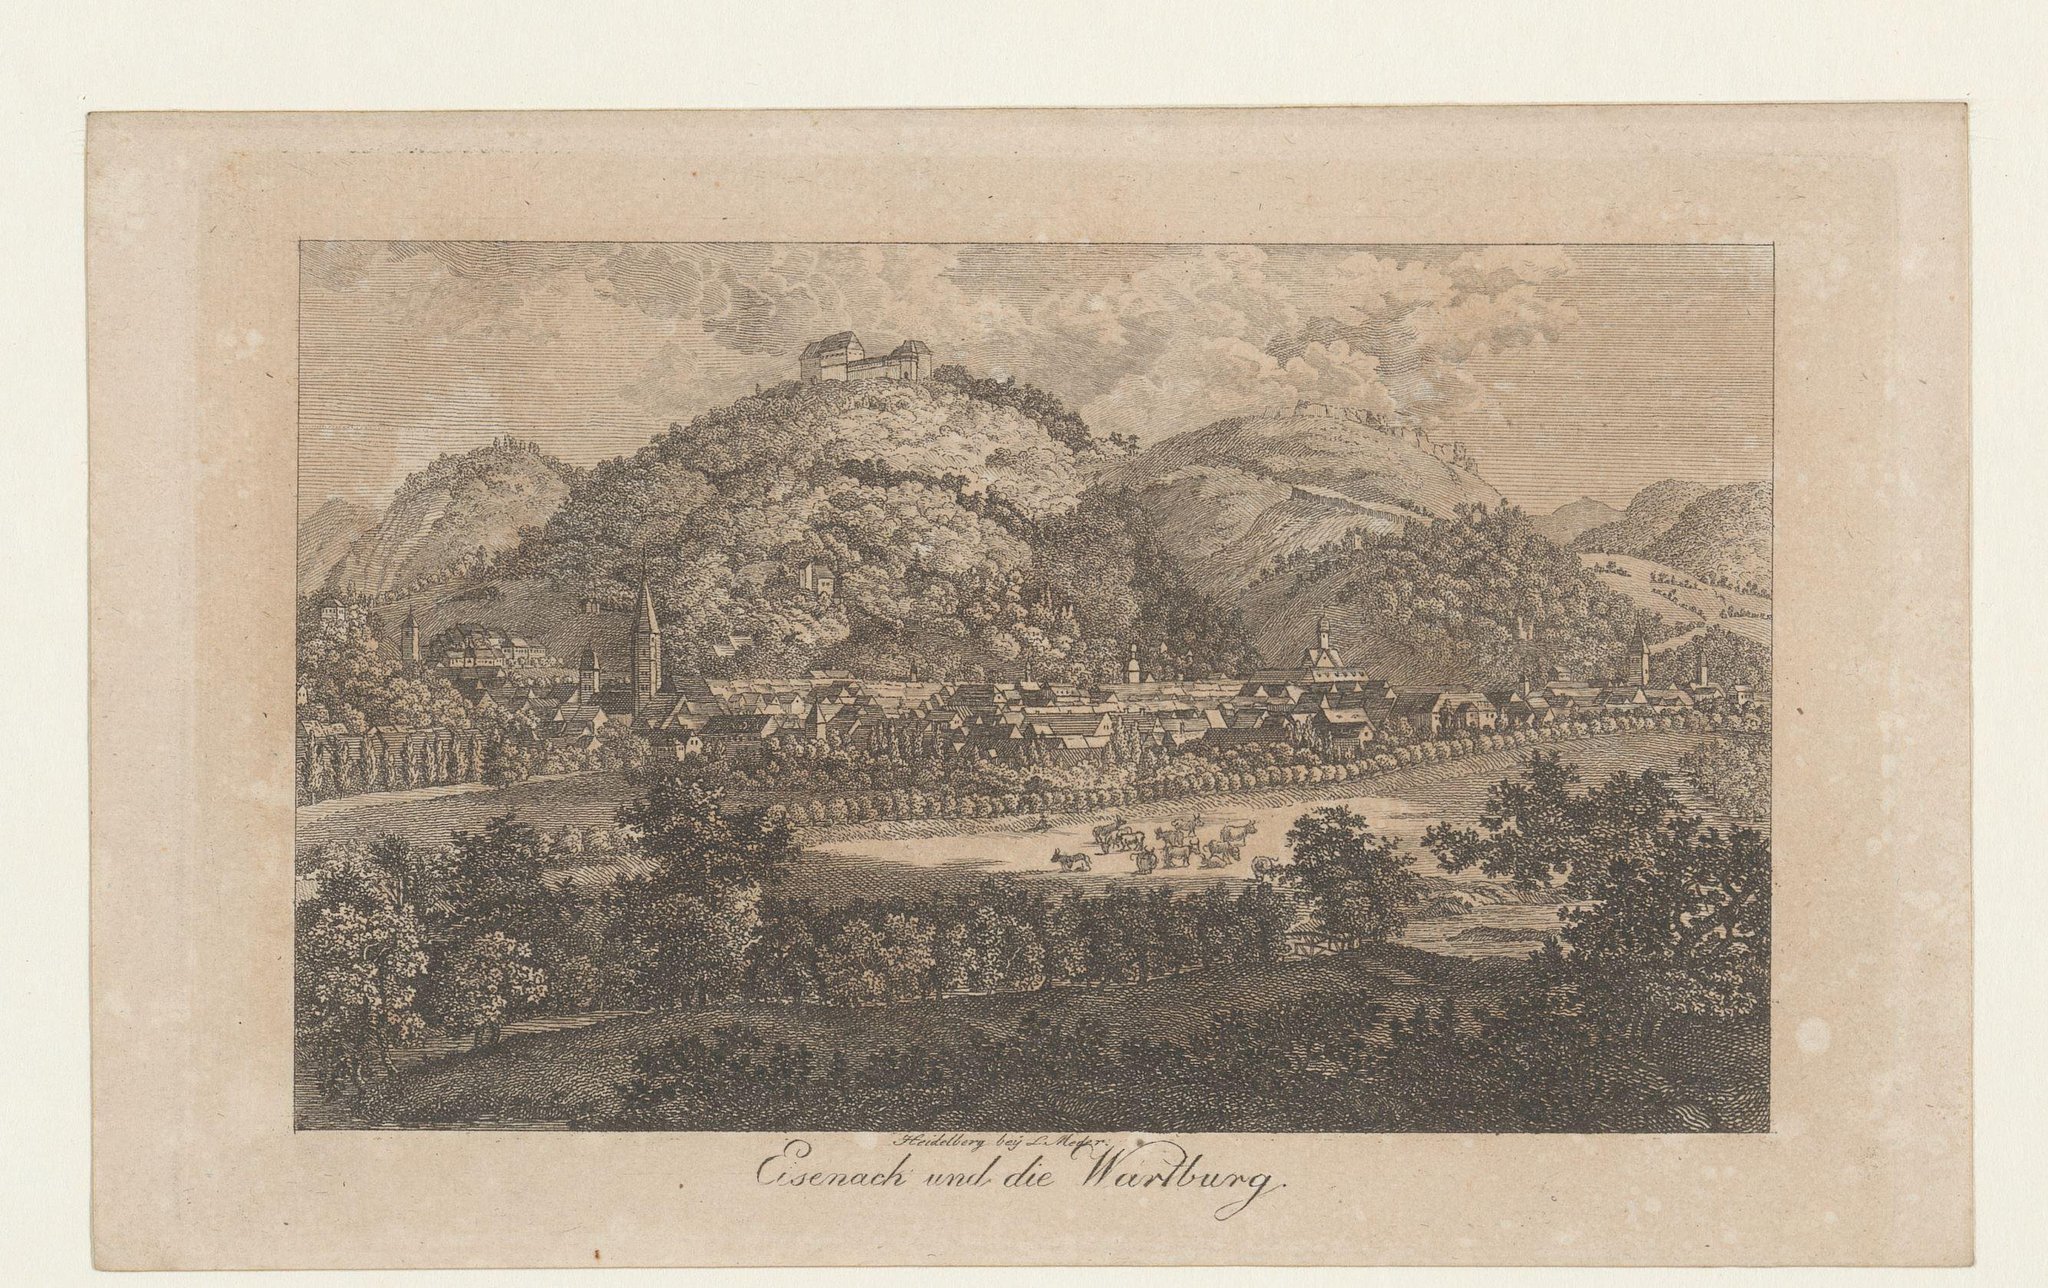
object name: print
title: Gezicht op Eisenach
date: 1850-1899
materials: paper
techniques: etching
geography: heidelberg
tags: prospect of village, silhouette of village, (high) hill - hh - ideal landscapes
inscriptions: collector's mark: Lugt 2228